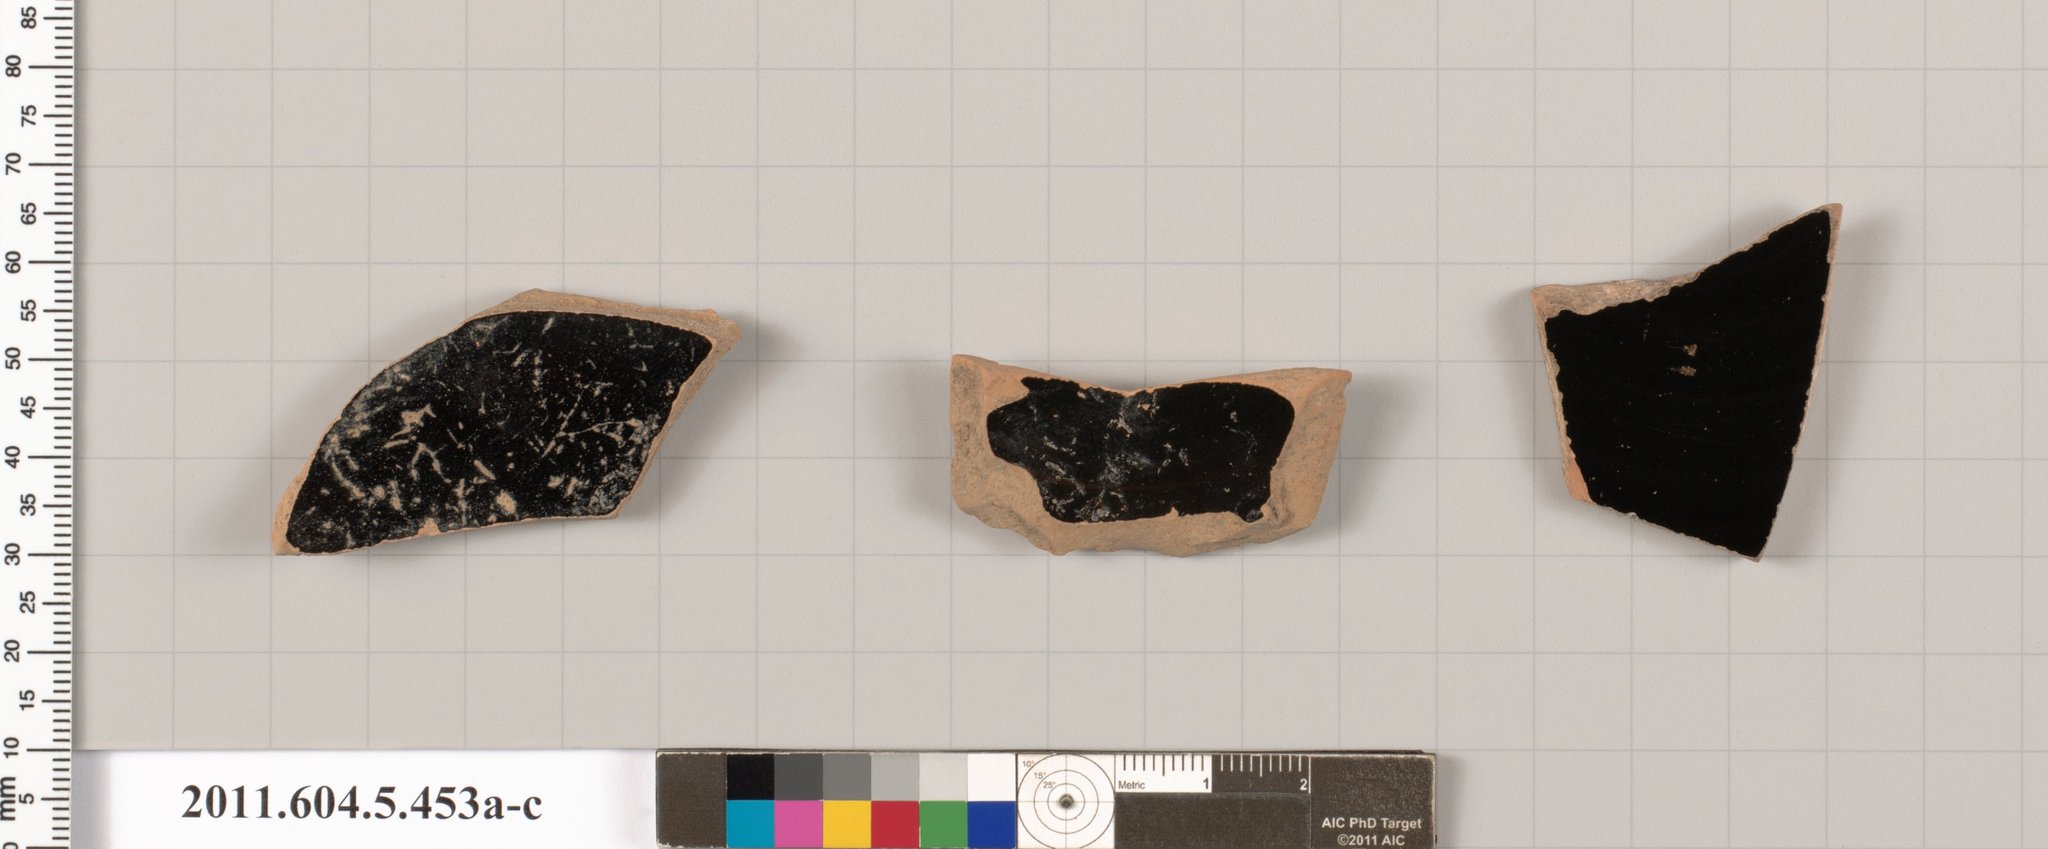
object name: kylix fragment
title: Terracotta fragments of kylikes (drinking cups)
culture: greek, attic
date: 600-401 BCE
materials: terracotta